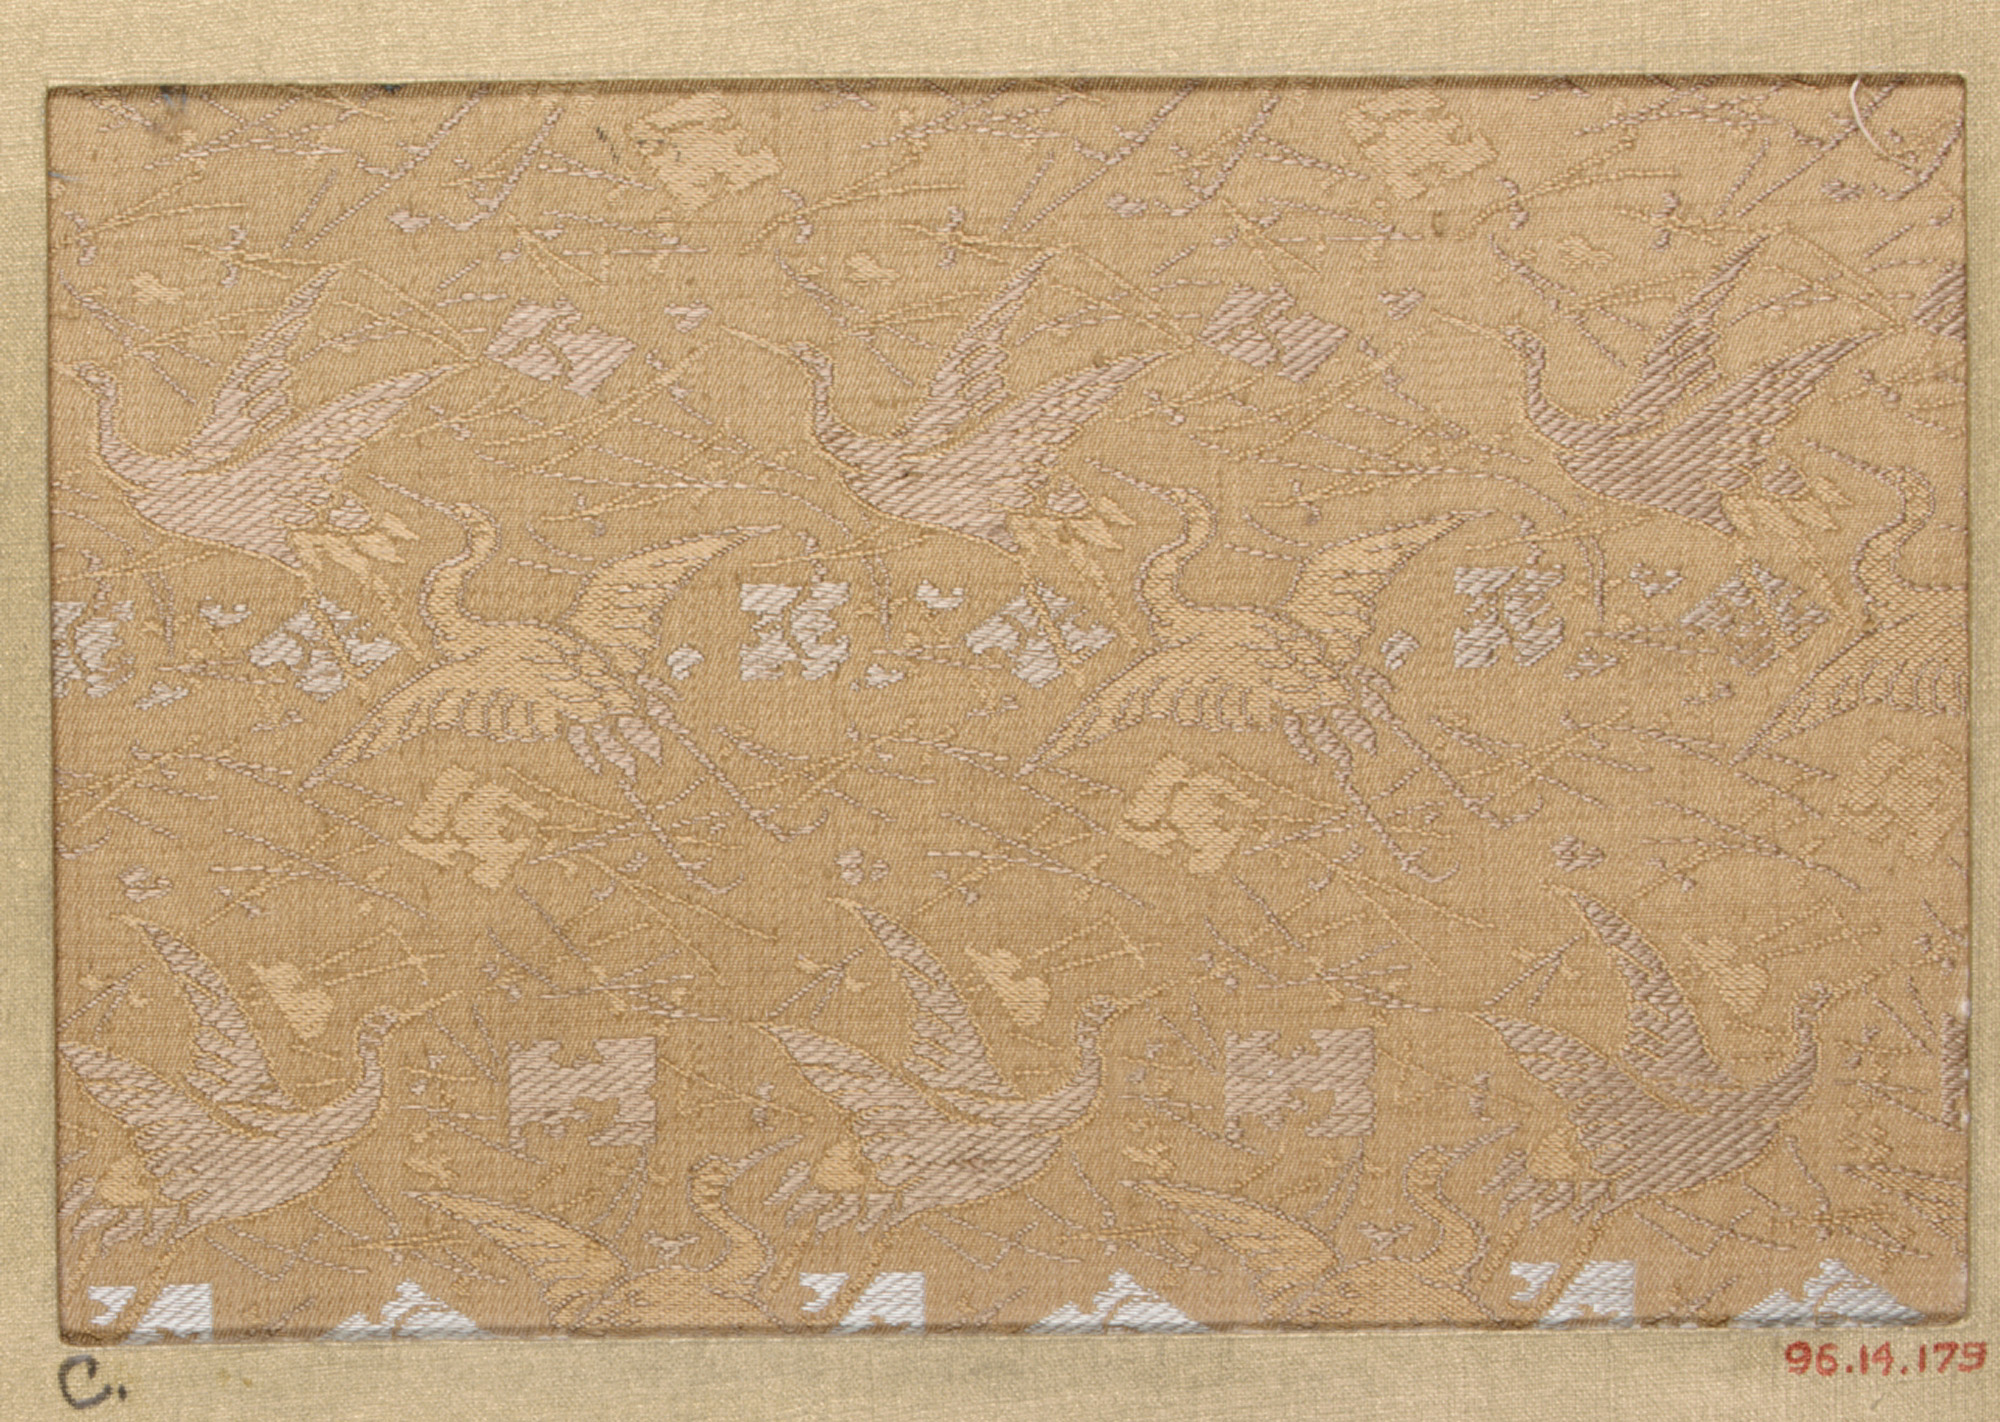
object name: piece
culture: japanese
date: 1701-1900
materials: silk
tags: cranes